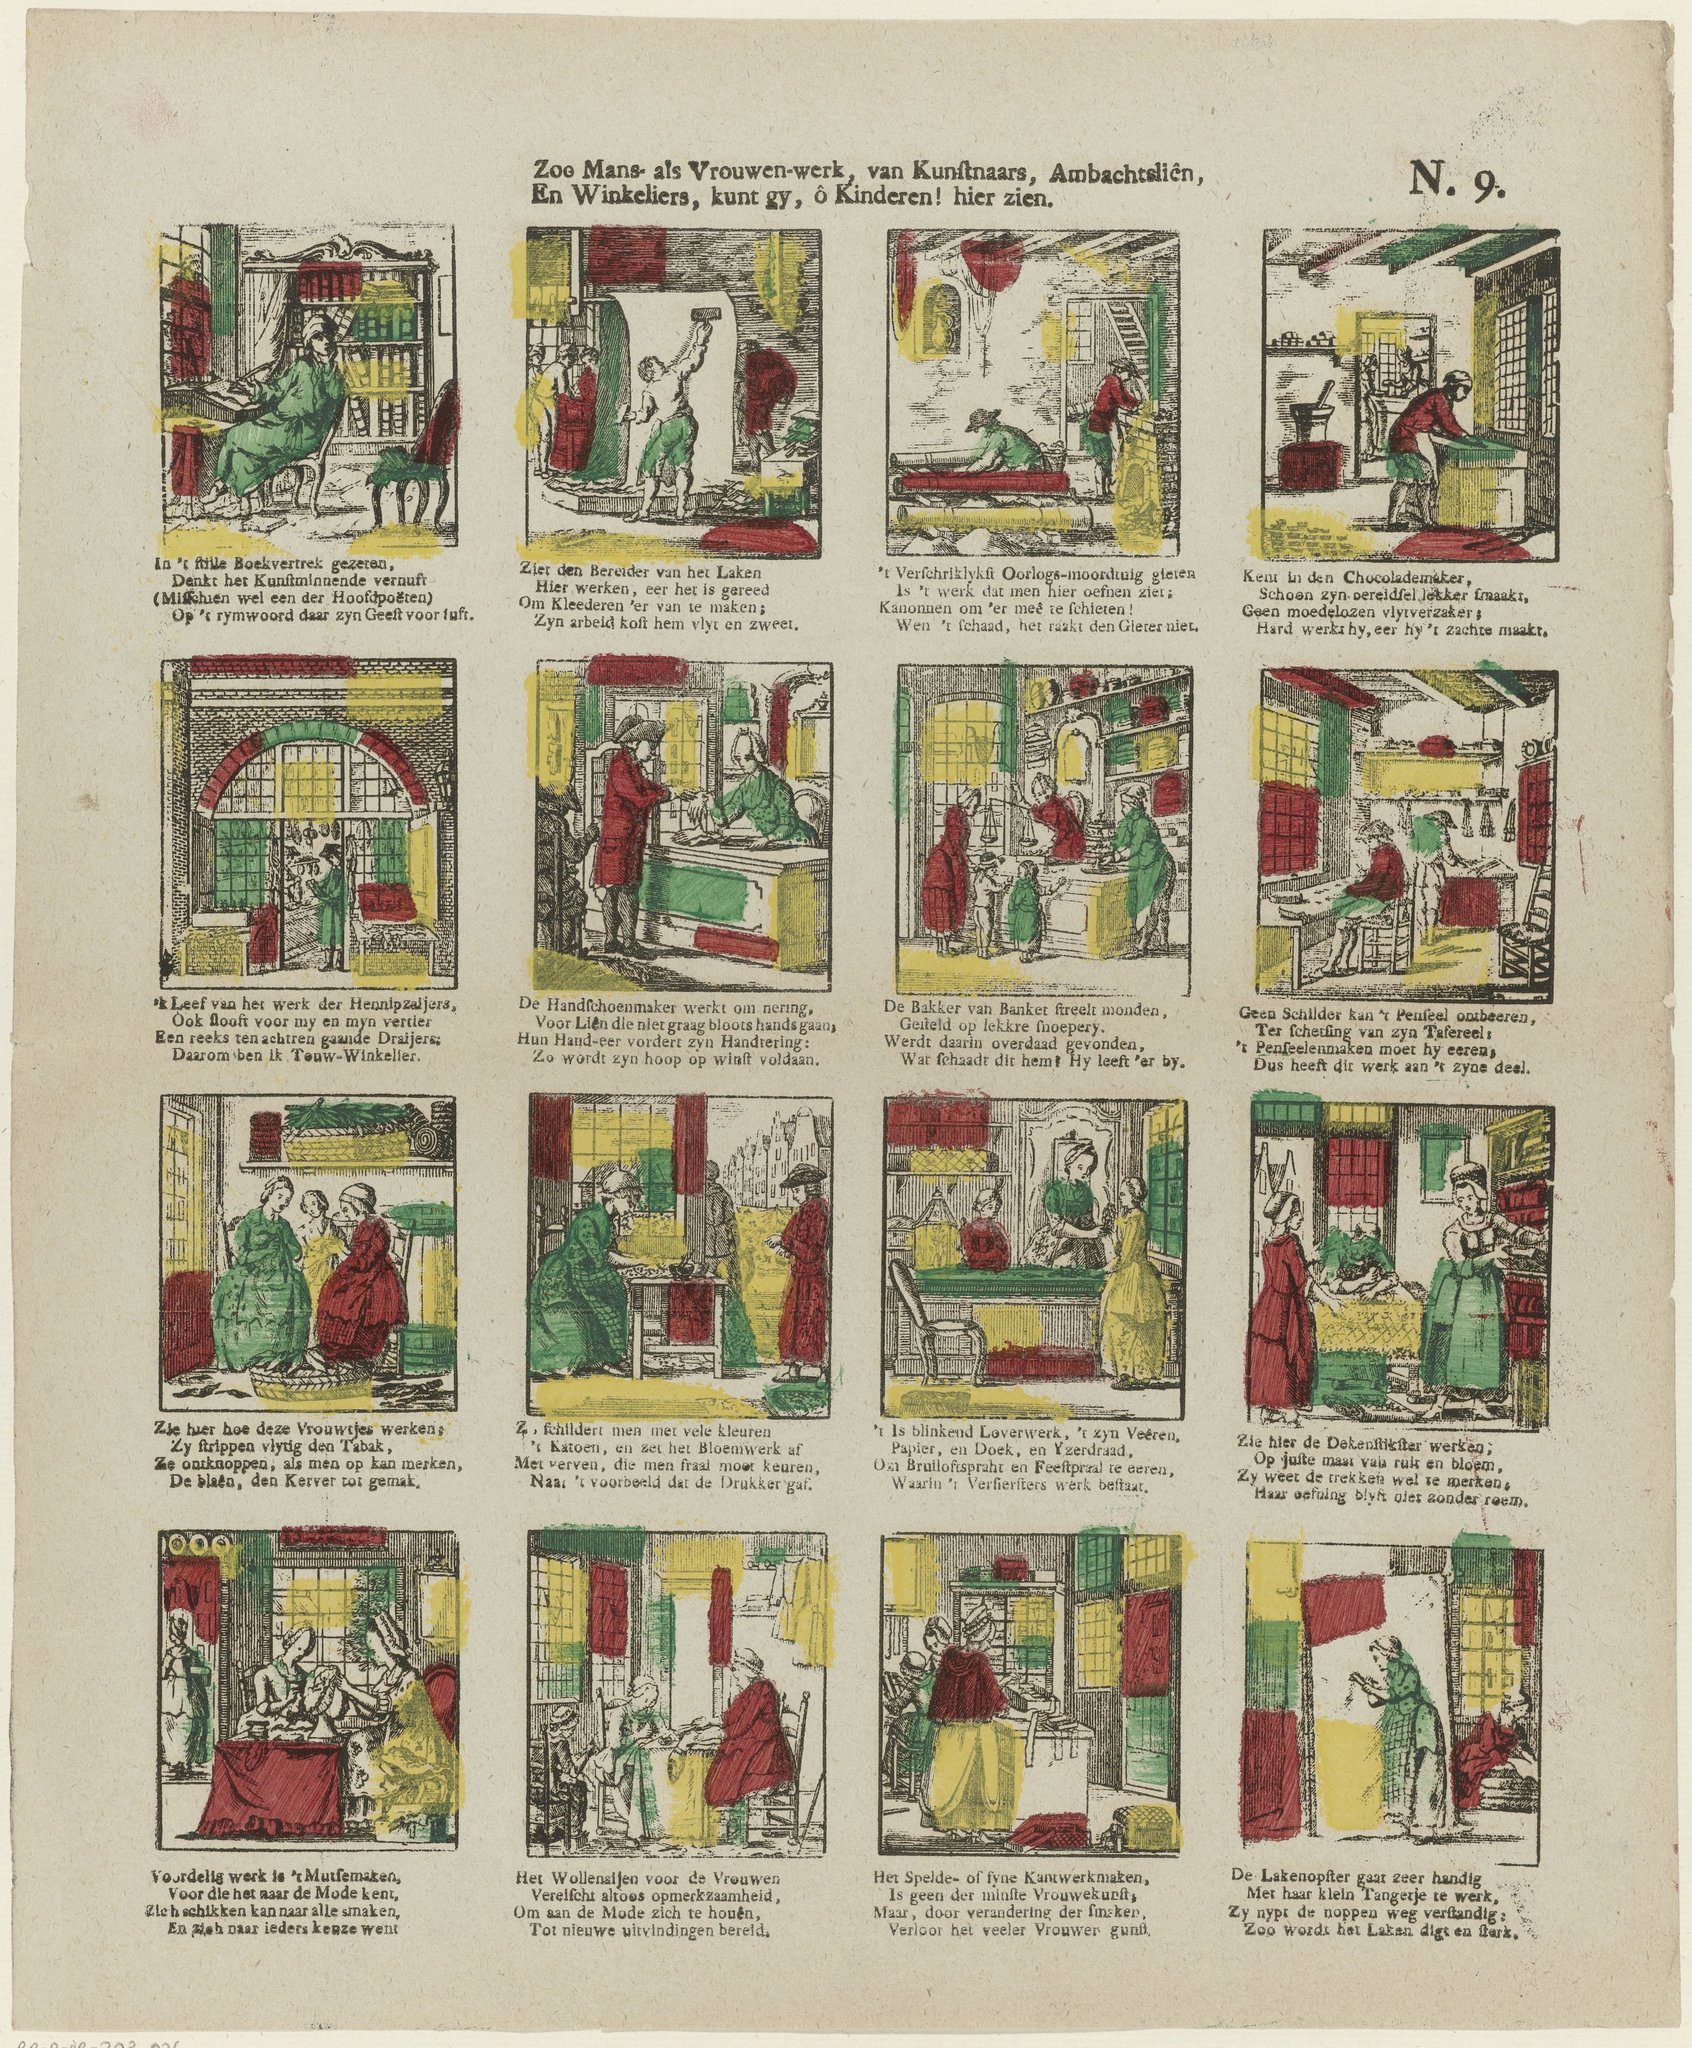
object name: popular print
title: Zoo mans als vrouwen-werk, van kunstenaars, ambachtliên, / En winkeliers, kunt gy, ô kinderen! hier zien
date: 1856-1900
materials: paper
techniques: colour, letterpress printing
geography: turnhout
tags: craft-production, skilled handiwork, street-trader, crafts and industries, merchant, salesman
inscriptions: collector's mark: Lugt 2760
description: Blad met 16 voorstellingen van ambachtslieden en beroepen, zoals touwverkoper, handschoenenmaker en penselenmaker. Onder elke afbeelding een vierregelig vers. Genummerd rechtsboven: N. 9.